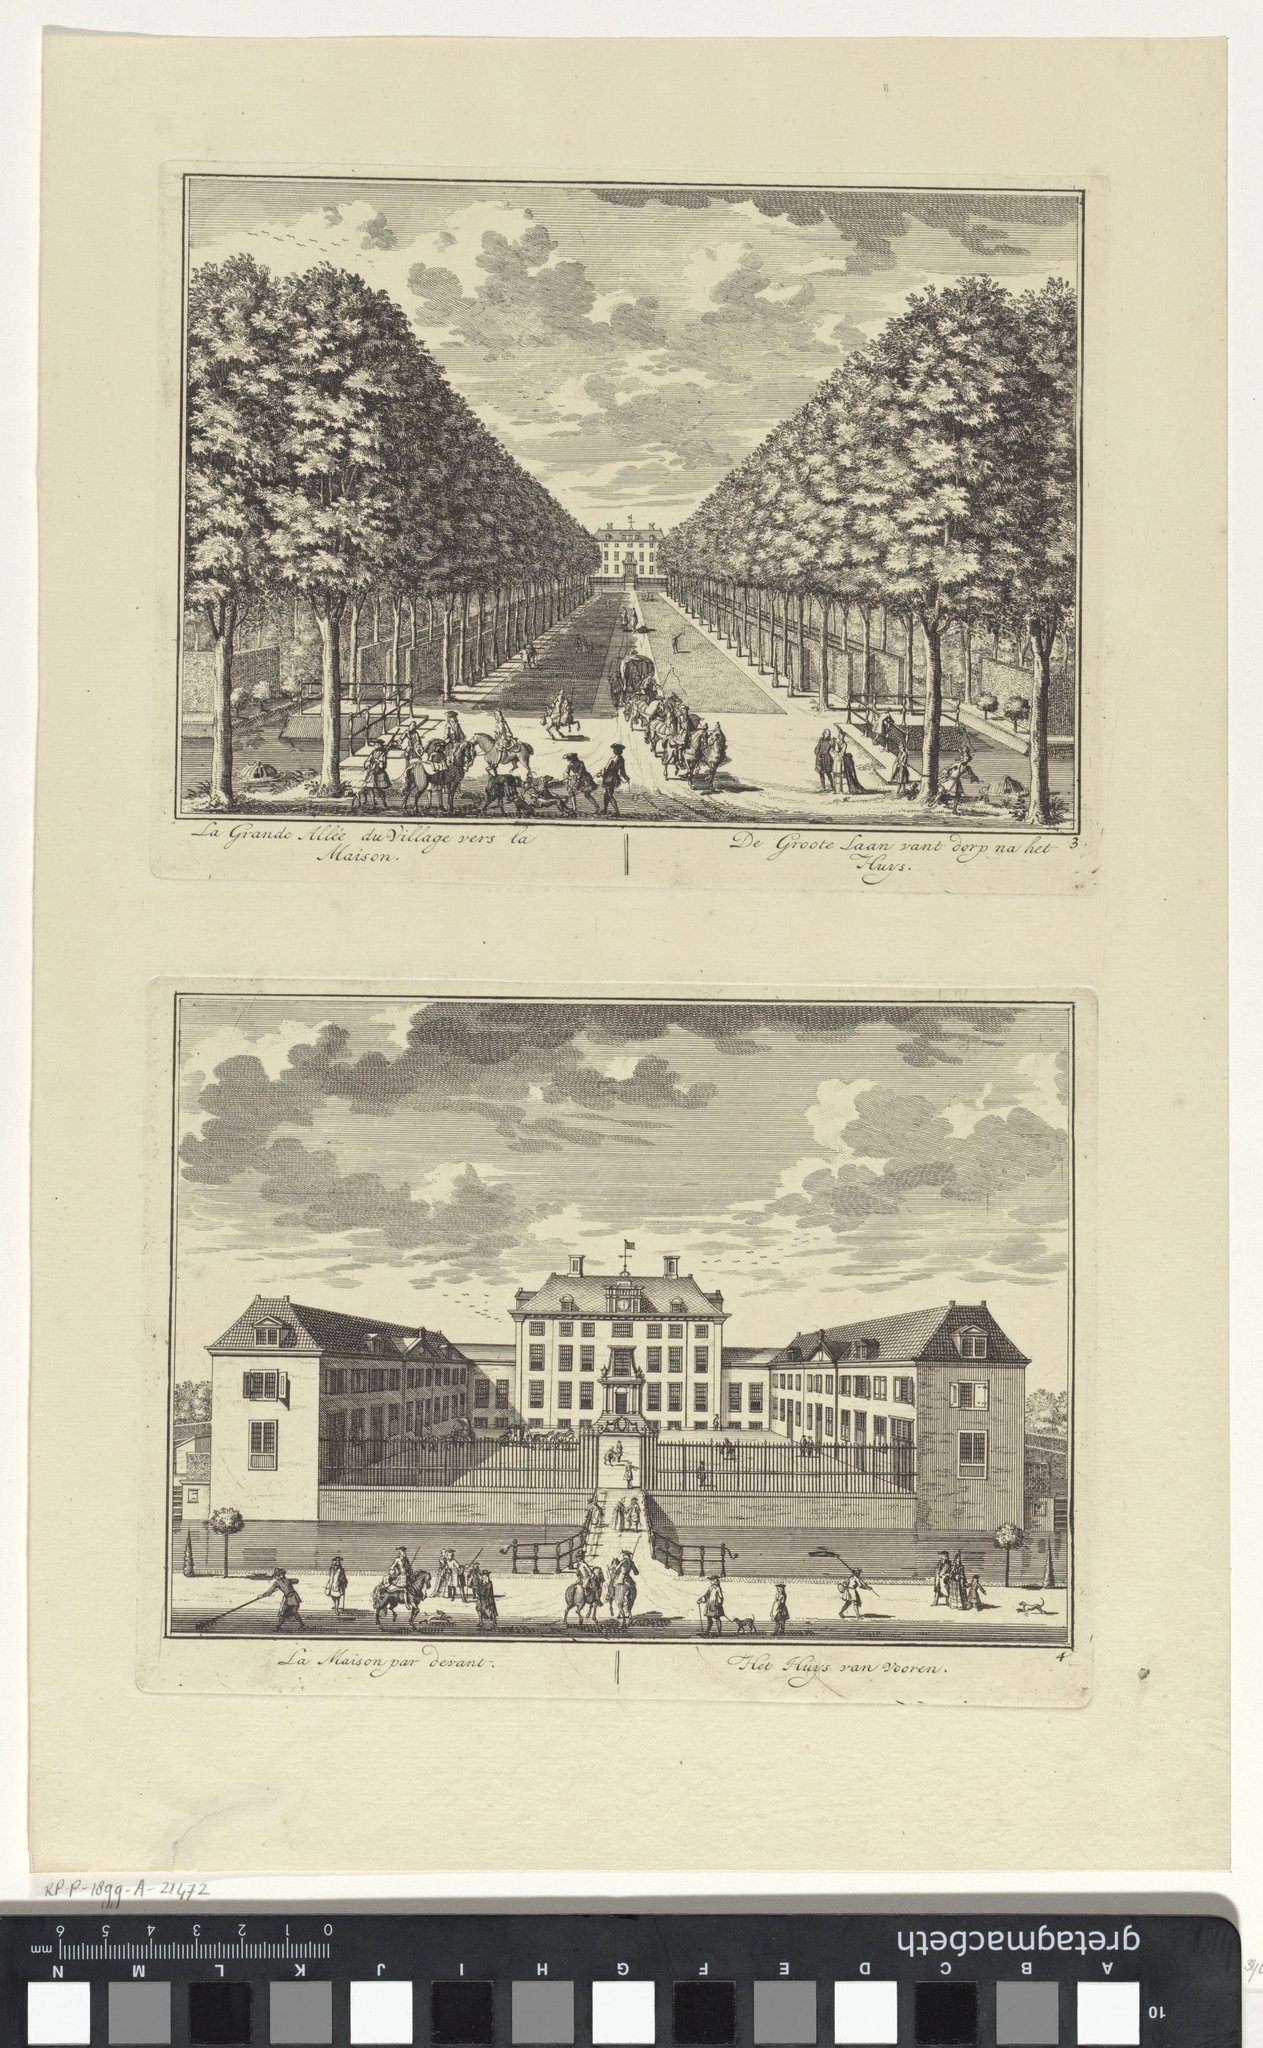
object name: print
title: Grote laan naar Slot Zeist / Voorzijde van Slot Zeist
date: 1682-1726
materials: paper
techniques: etching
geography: amsterdam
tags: rural housing, e.g. country-house, villa, cottage, exterior ~ representation of a building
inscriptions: collector's mark: Lugt 2228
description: Twee voorstellingen op een blad. Boven: Gezicht op de toegangslaan van het dorp Zeist naar Slot Zeist. Op de voorgrond een koets en figuren met honden. Onder: Vooraanzicht van Slot Zeist.